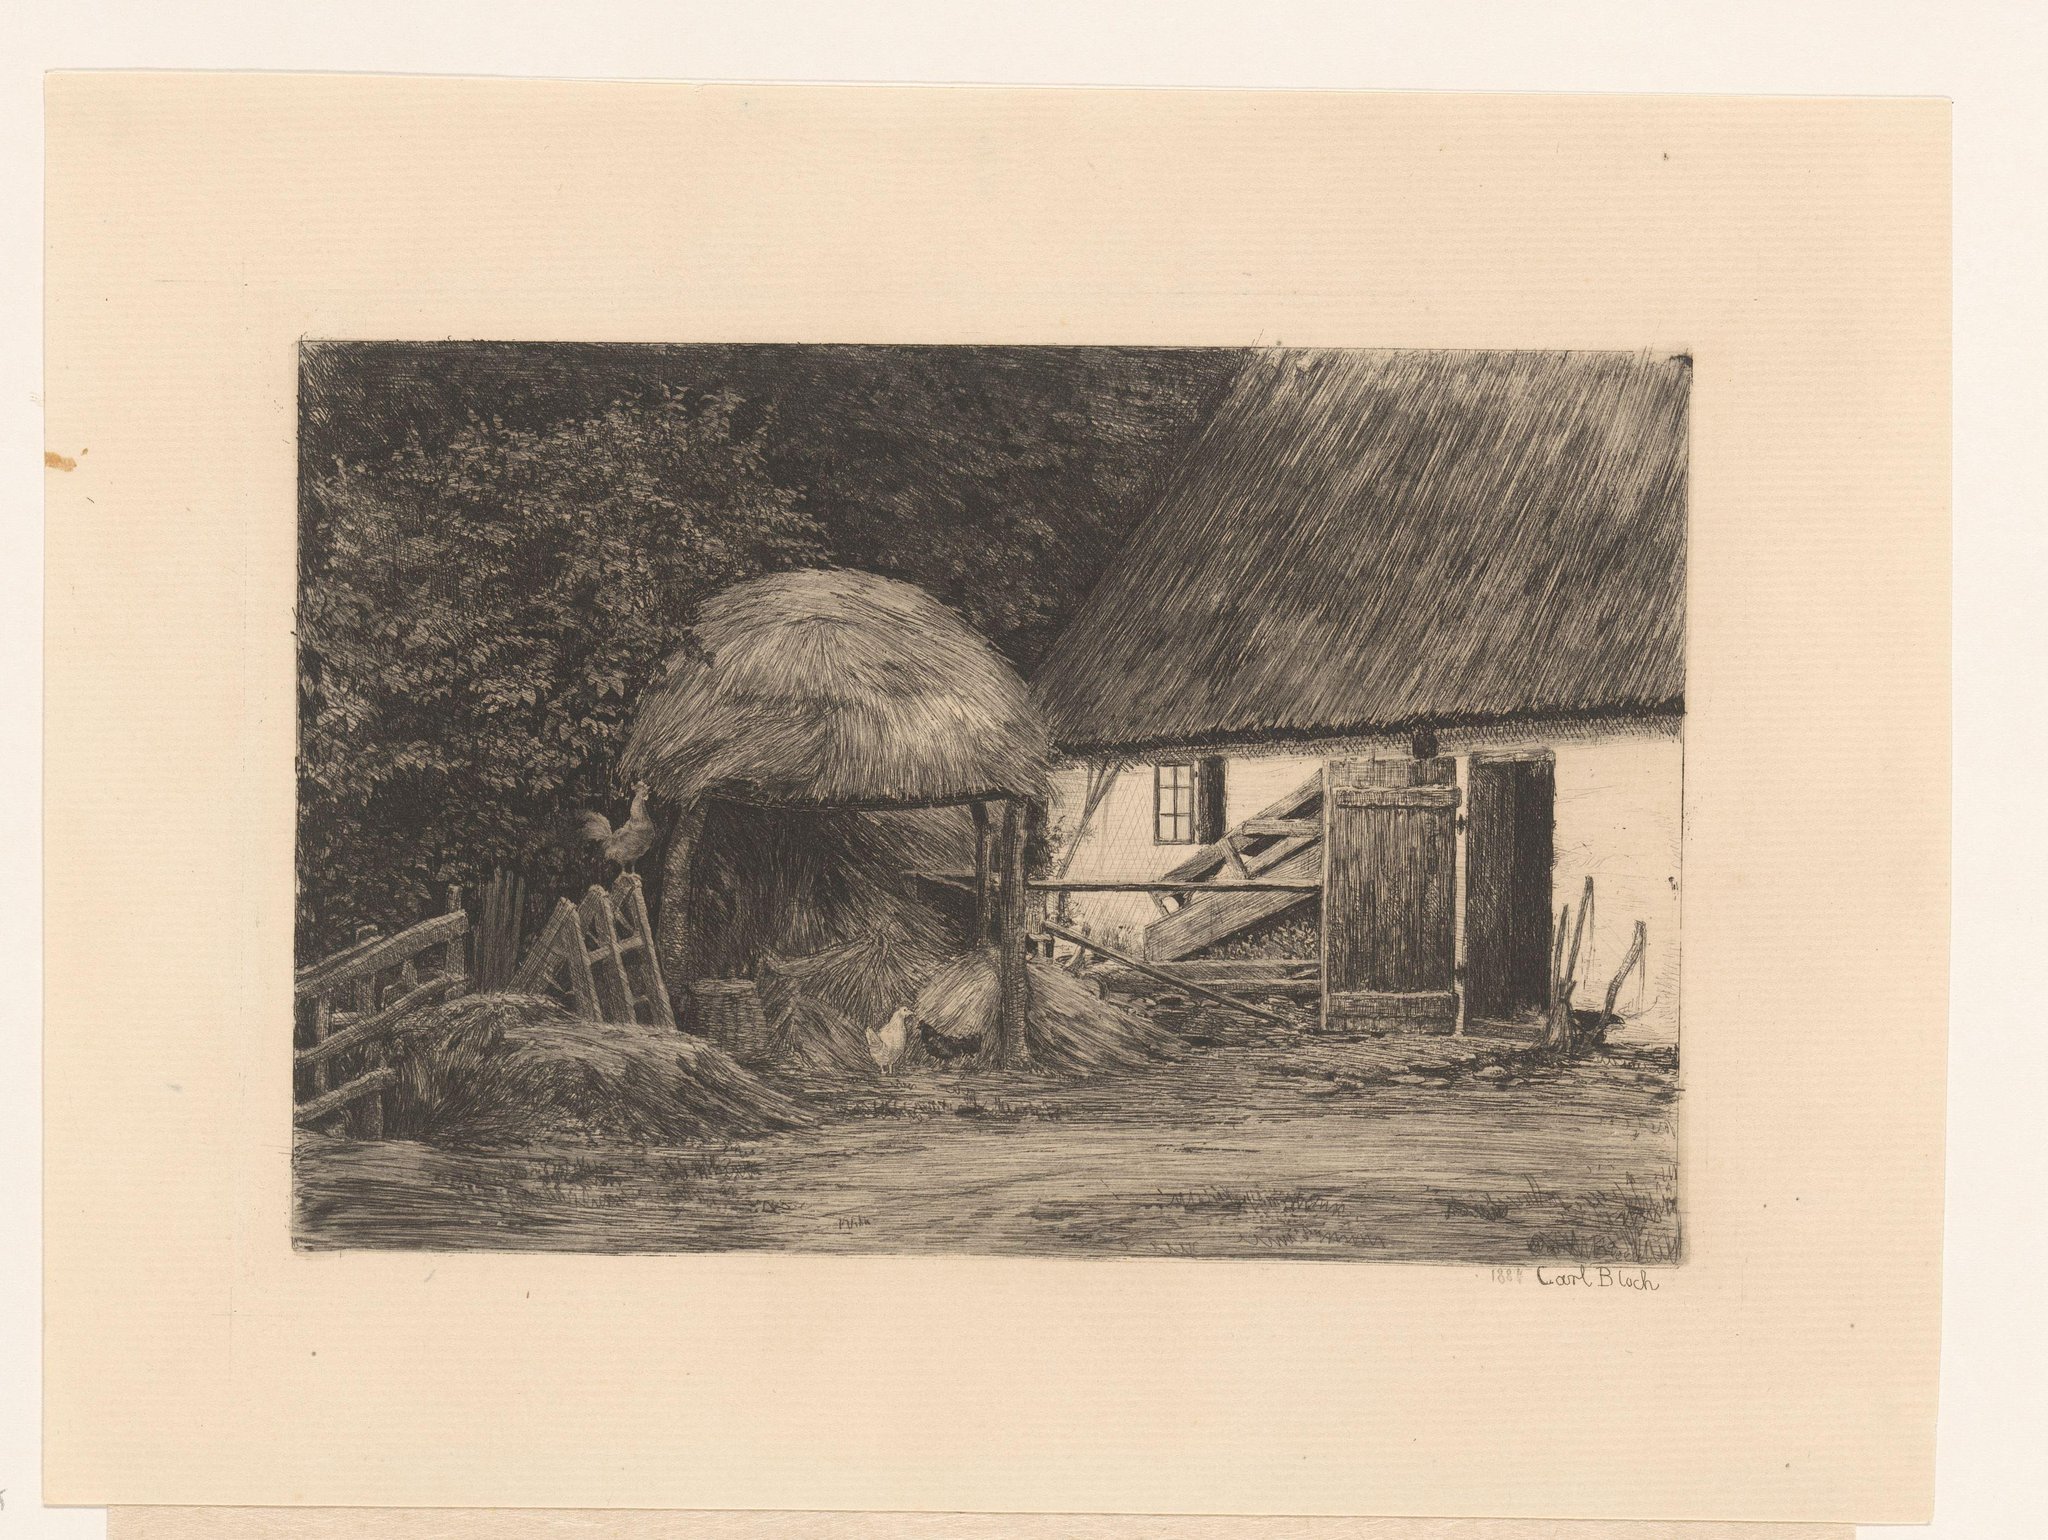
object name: print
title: Boerenerf met hooimijt en kippen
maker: carl bloch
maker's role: print maker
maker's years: 1834-1890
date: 1888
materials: paper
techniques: drypoint, etching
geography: scandinavia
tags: hay-stack, farm (building)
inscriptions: signature and date: ‘r.o. in de marge gesigneerd en gedateerd Carl Bloch 1888’, collector's mark: Lugt 2228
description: Boerenerf met links een hooimijt waarbij scharreldende kippen. Rechts gedeelte van witte boerderij met openstaande deur. Links bomen.